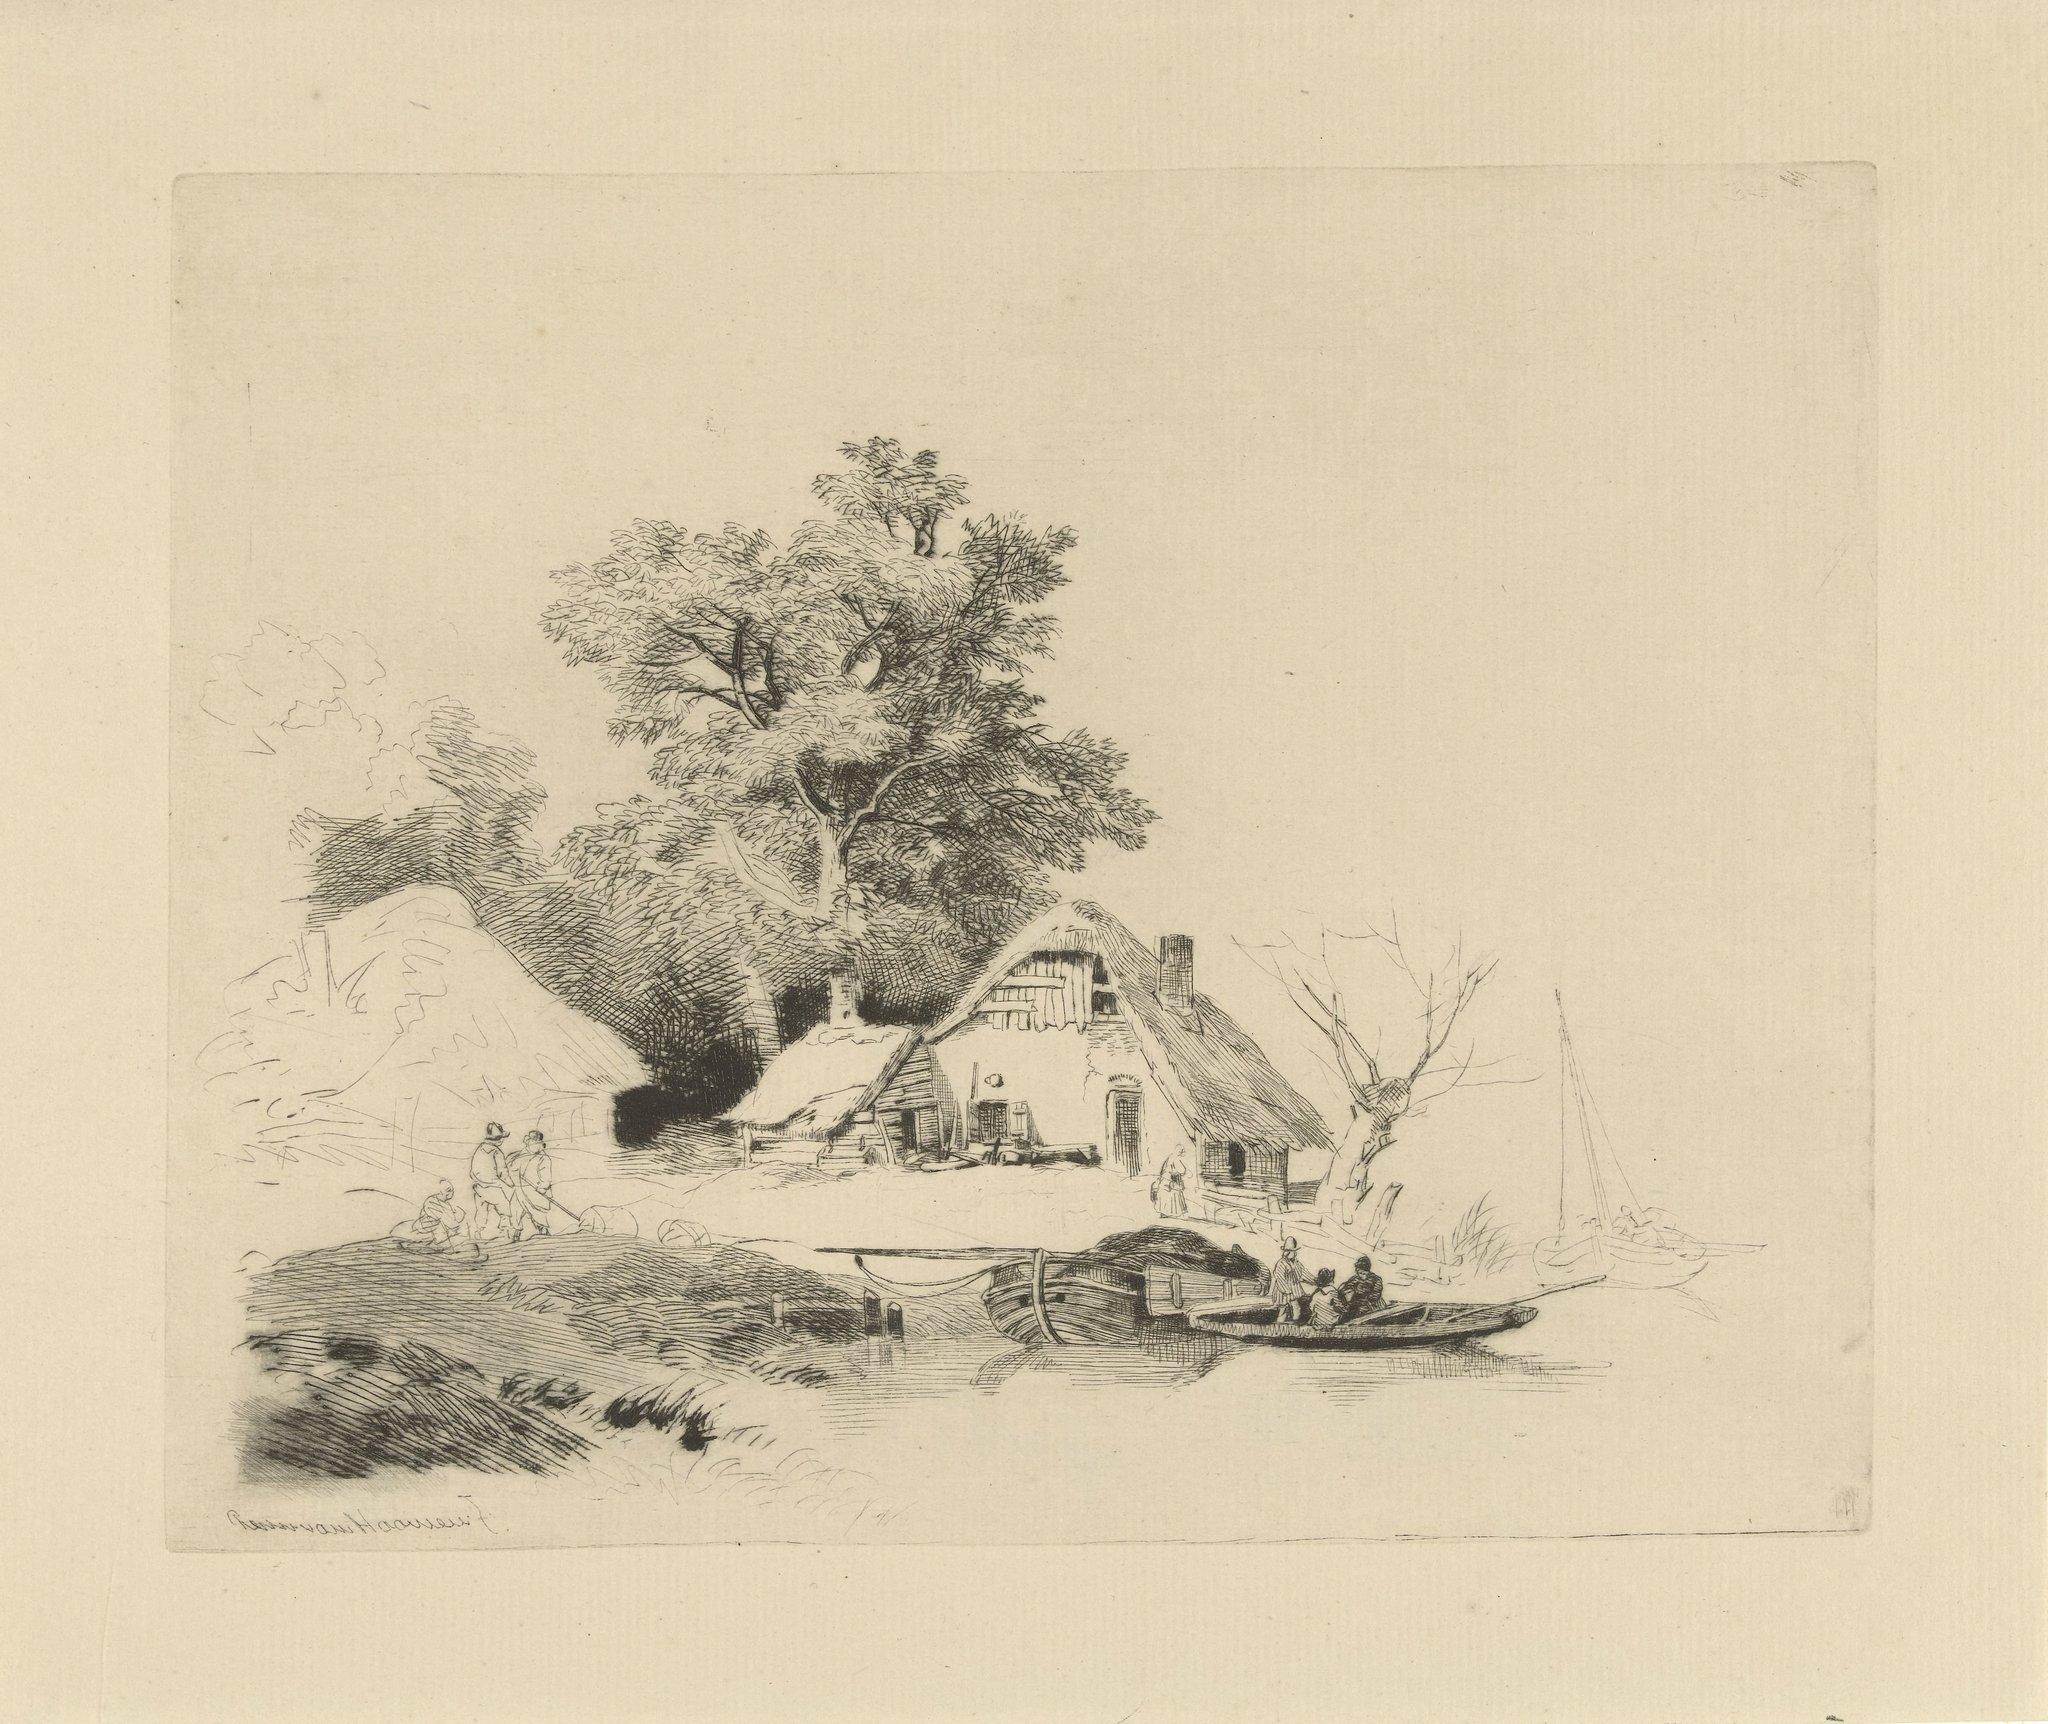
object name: print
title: Boerderij aan het water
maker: remigius adrianus haanen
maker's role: draughtsman, painter, print maker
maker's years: 1812-1894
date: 1827-1879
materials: paper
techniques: drypoint, etching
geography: austria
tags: farm or solitary house in landscape (+ city(-scape) with figures, staffage)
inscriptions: collector's mark: Lugt 2228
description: Een boerderij naast een bomenrij aan het water, twee boten aan de oever.